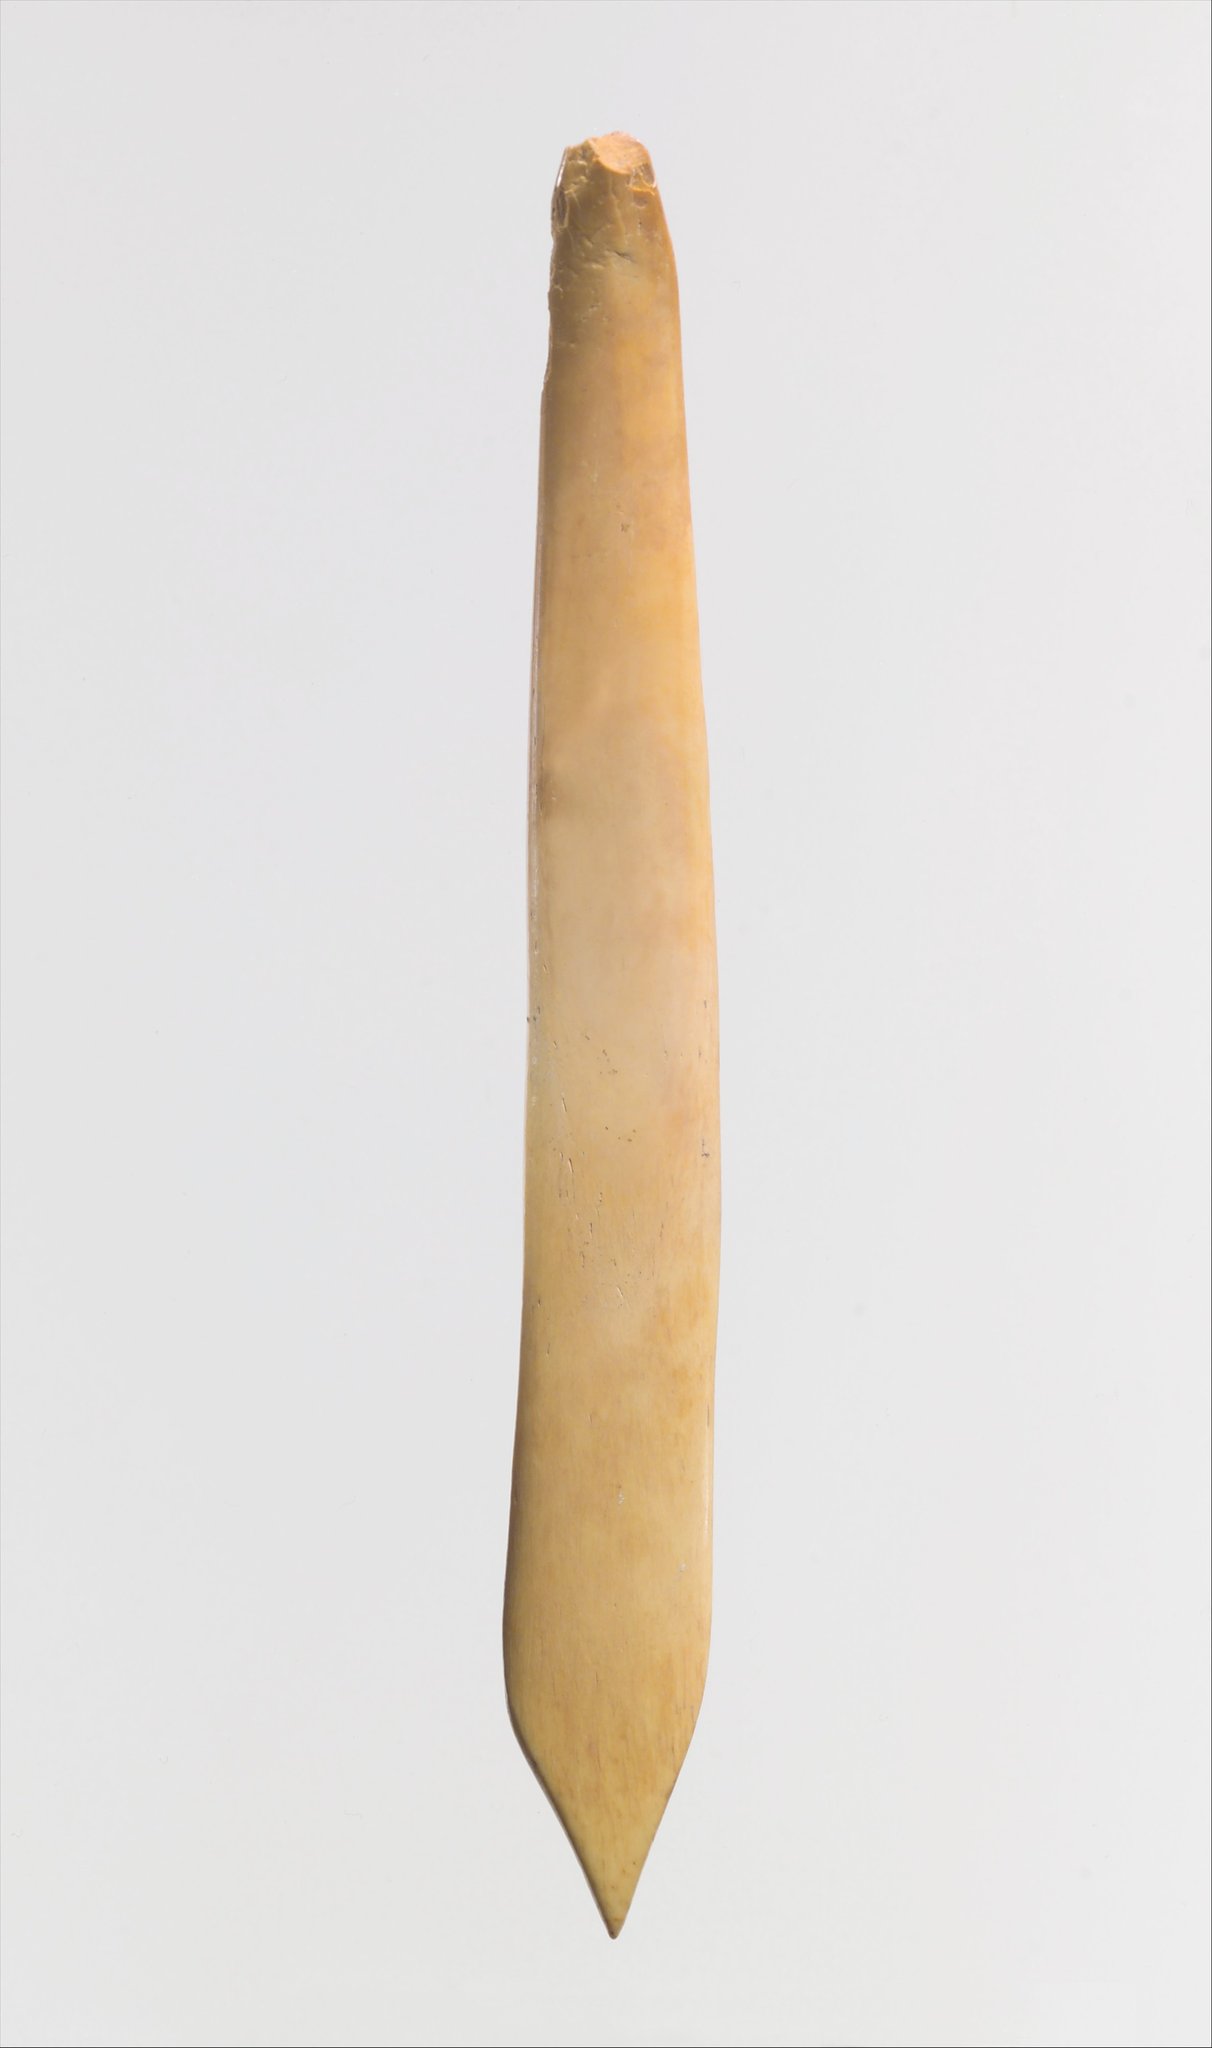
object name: stylus or bone point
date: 3000-1001 BCE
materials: bone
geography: mesopotamia